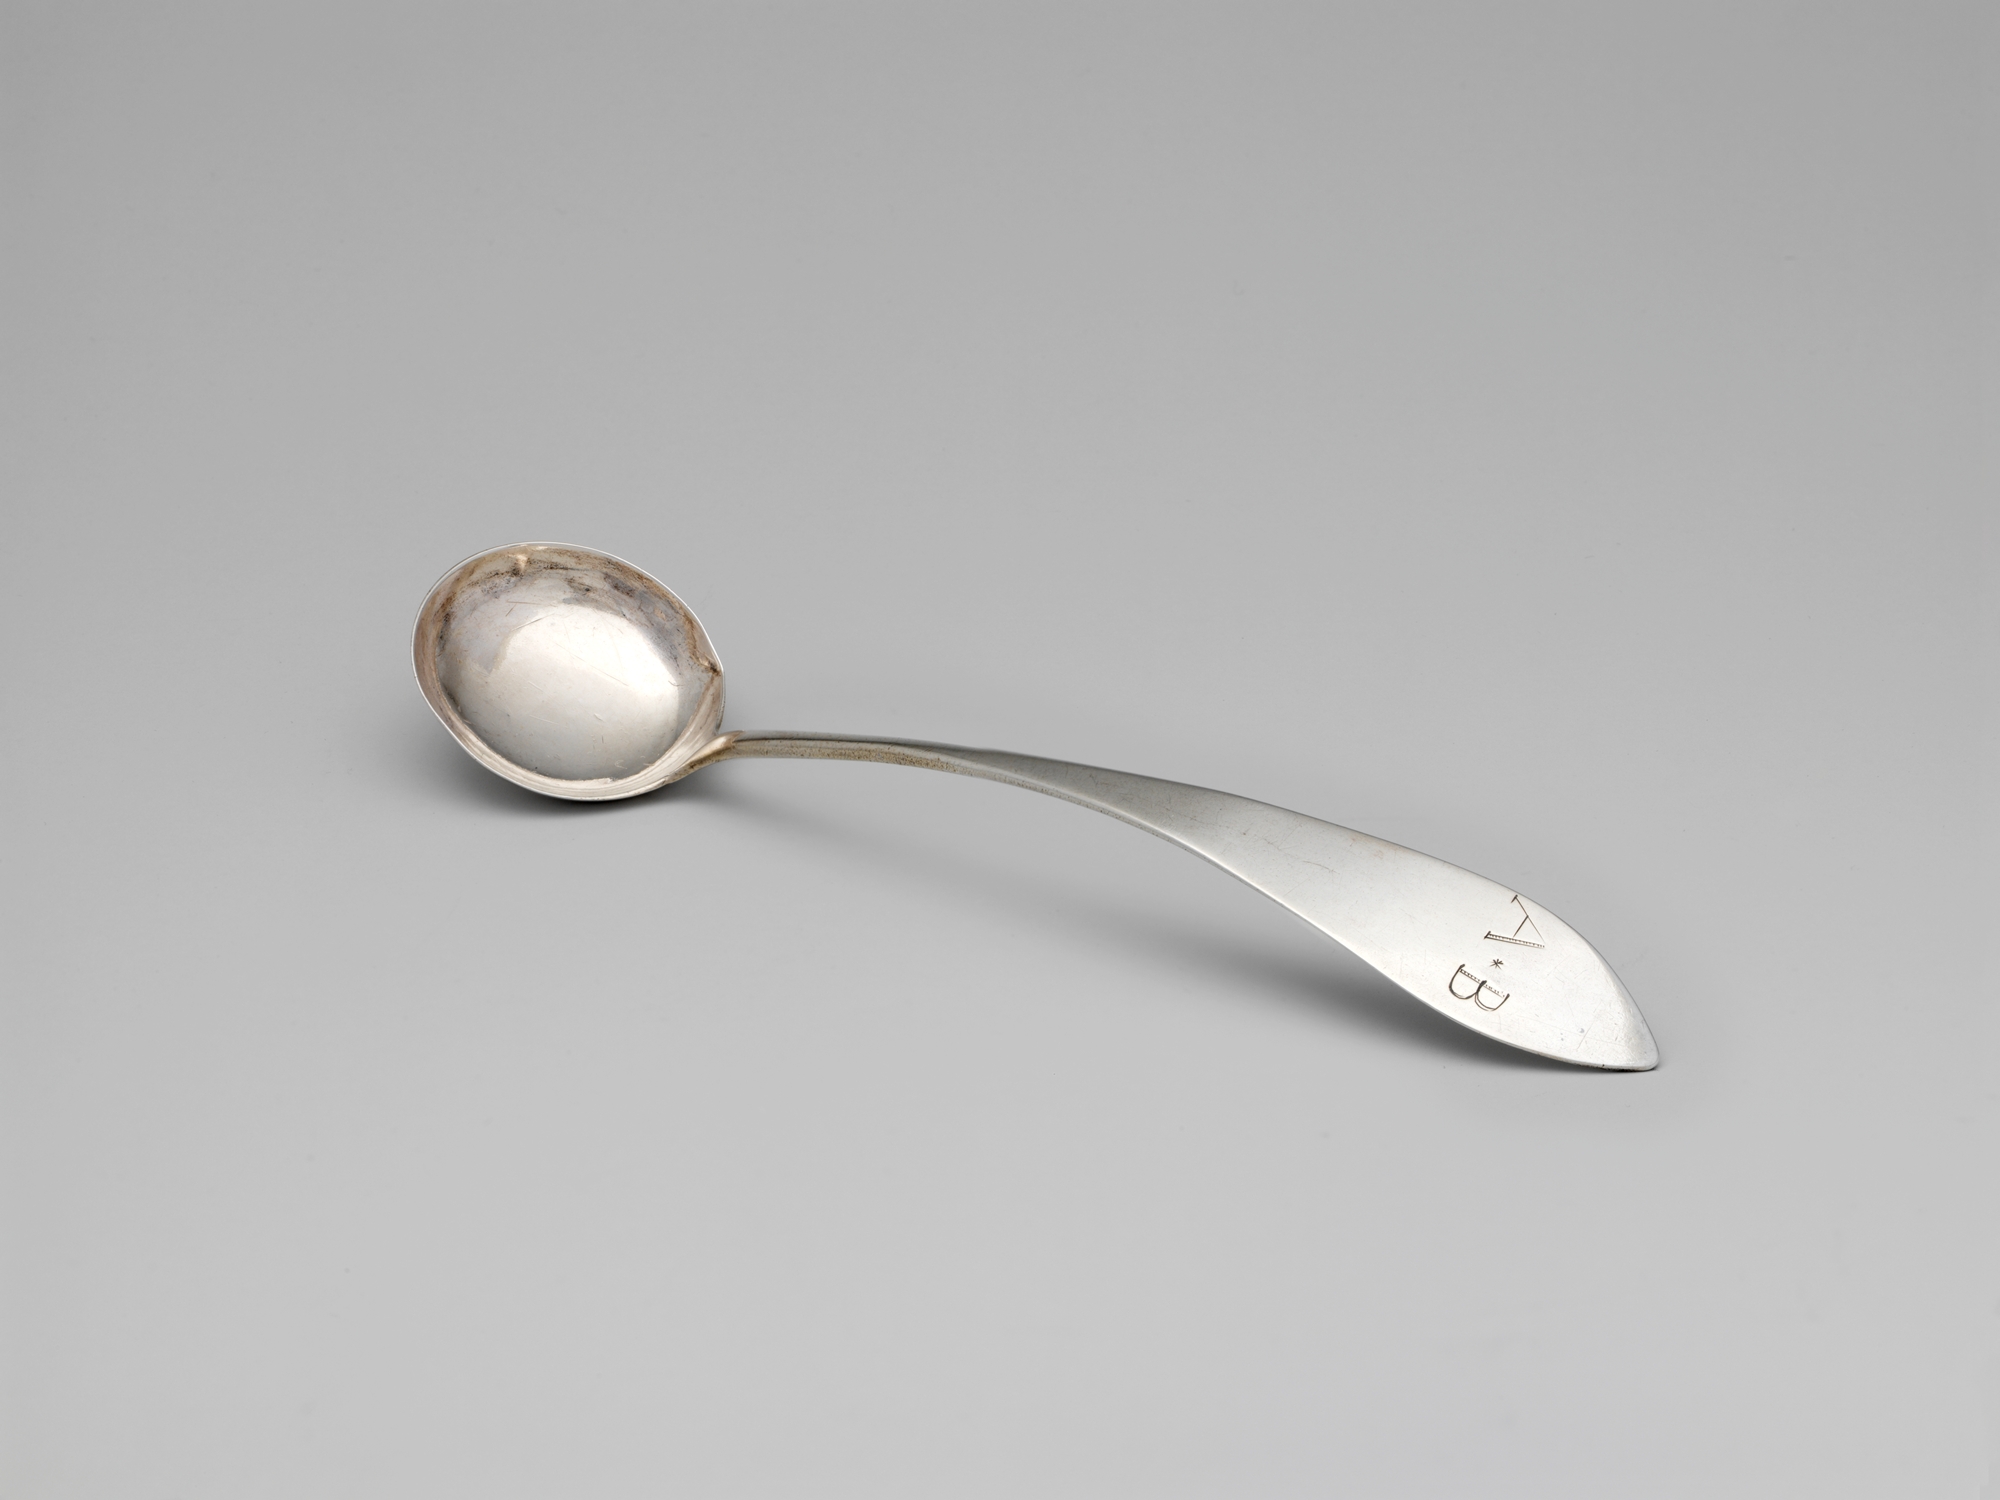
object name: ladle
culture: american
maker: saunders pitman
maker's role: maker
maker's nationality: american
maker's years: 1732-1804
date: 1770-1800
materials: silver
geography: united states